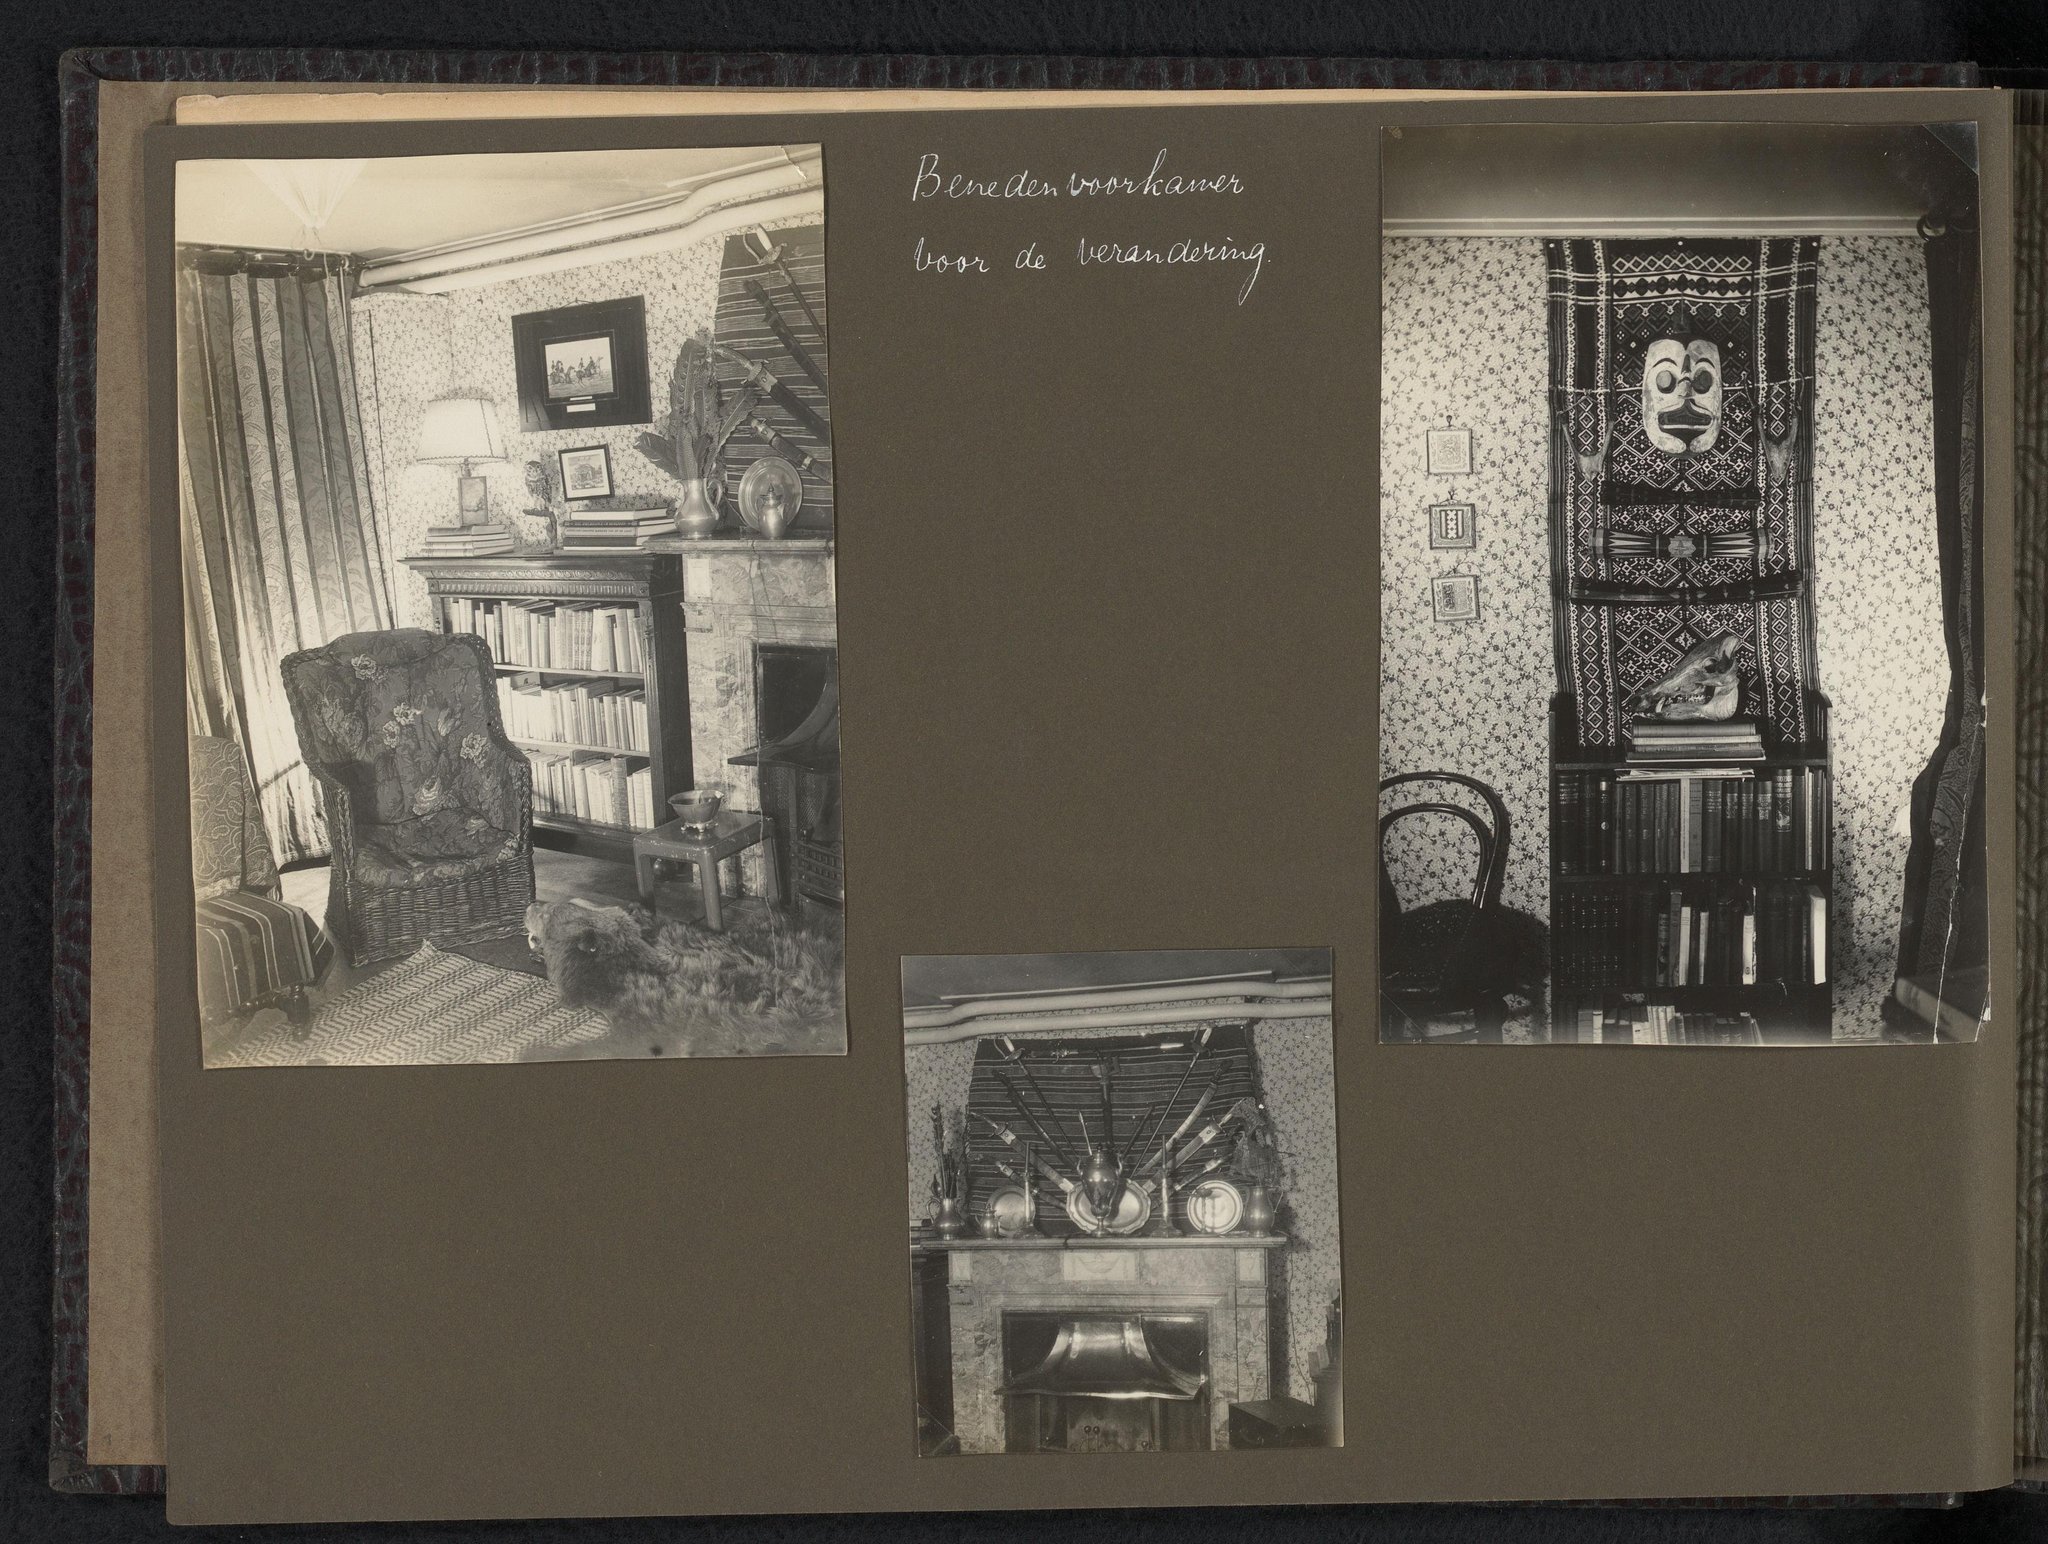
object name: album leaf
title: Drie foto's van de voorkamer beneden van Keizersgracht 806-808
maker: frank willem van den berg (1912-1998)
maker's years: 1912-1998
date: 1930-1931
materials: paper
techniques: gelatin silver print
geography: amsterdam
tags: living-room, parlour, sitting-room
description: Deze foto's maken deel uit van een album.